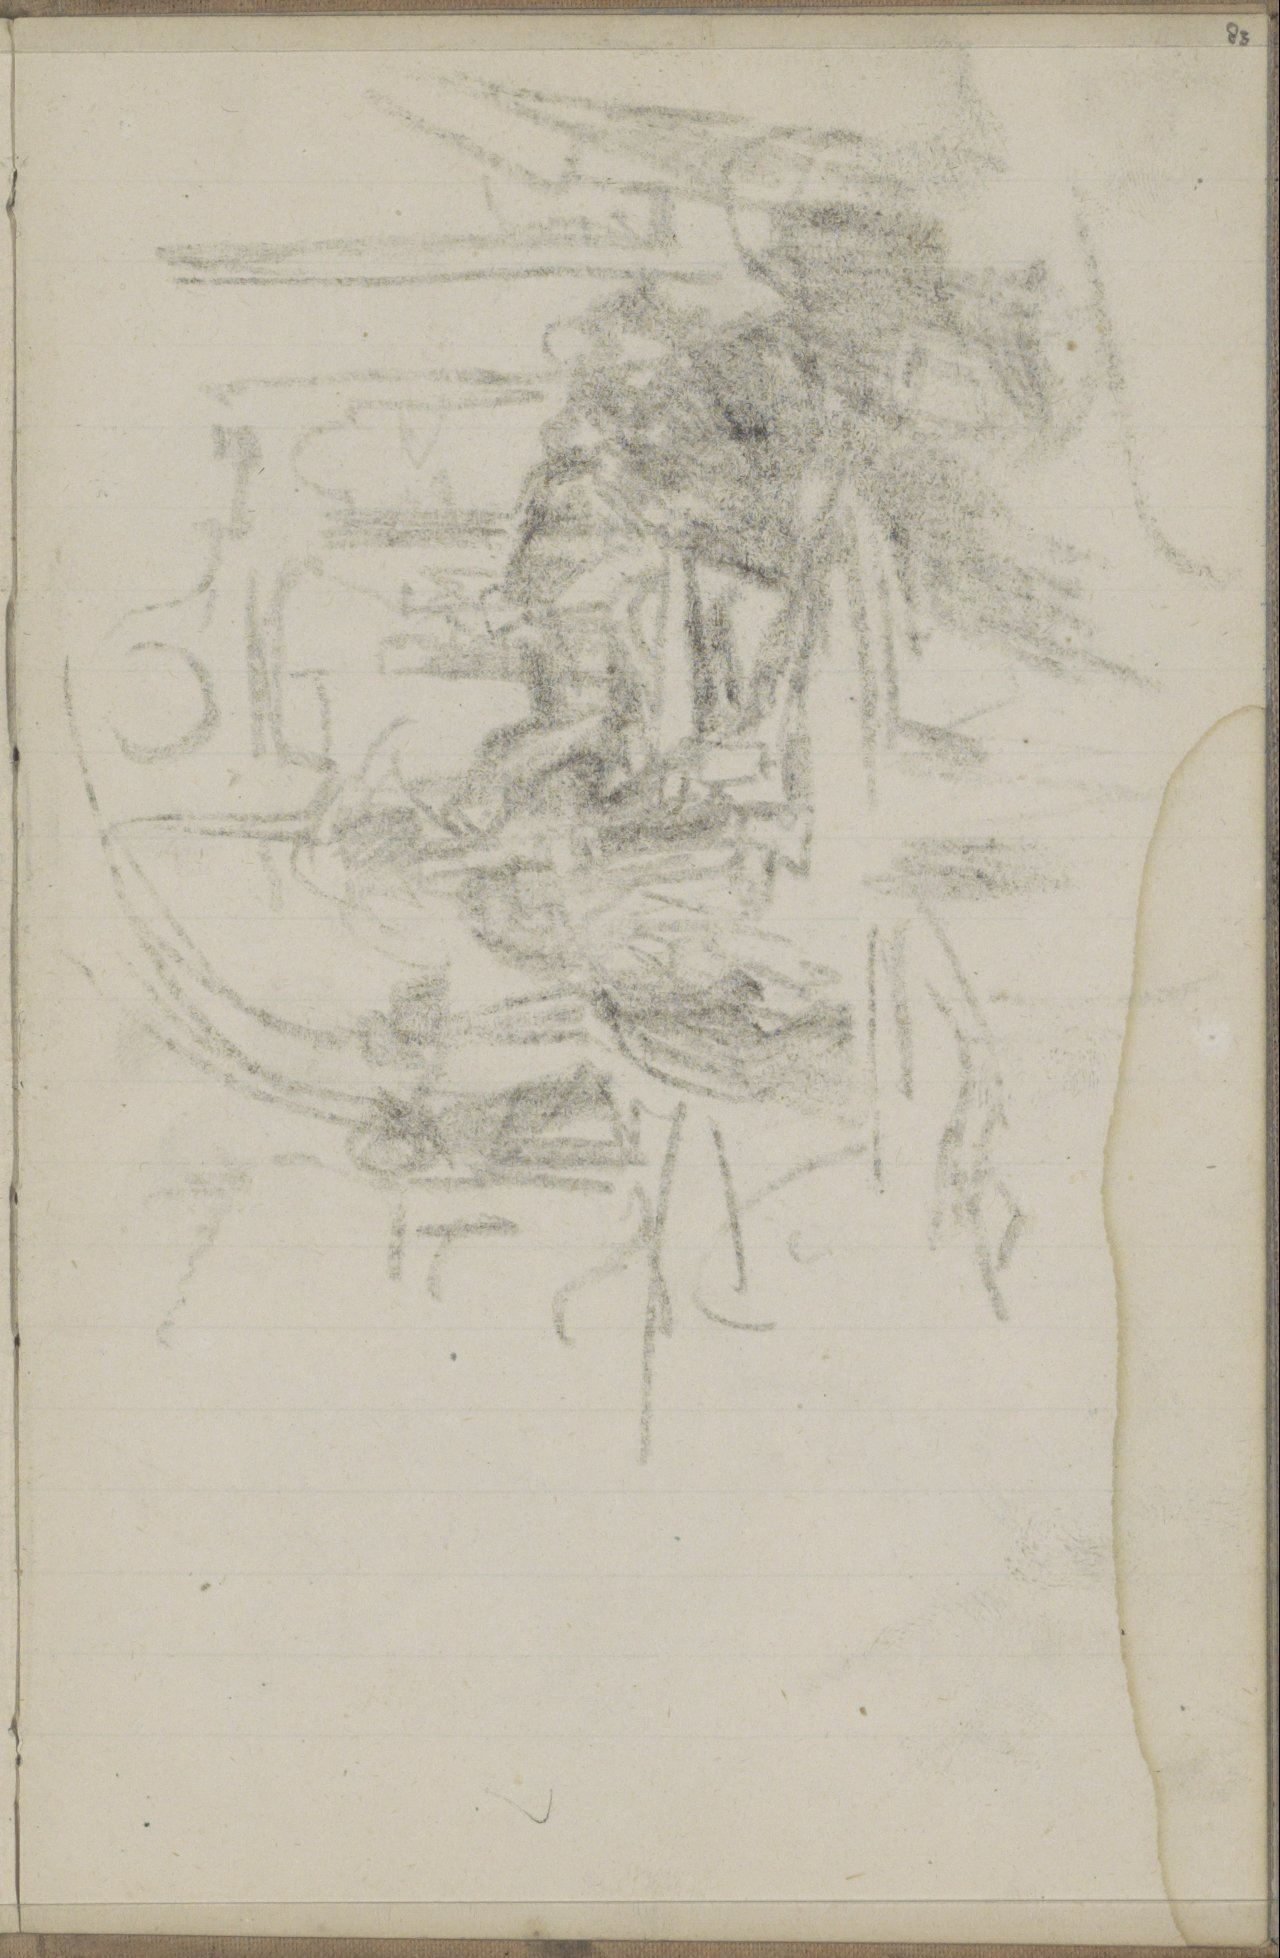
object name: sketchbook leaf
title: Abklatsch van de krijttekening op pagina 82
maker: marius bauer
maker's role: draughtsman, print maker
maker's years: 1867-1932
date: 1888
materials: lined paper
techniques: printmaking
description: Pagina 83 uit een schetsboek met 49 bladen.